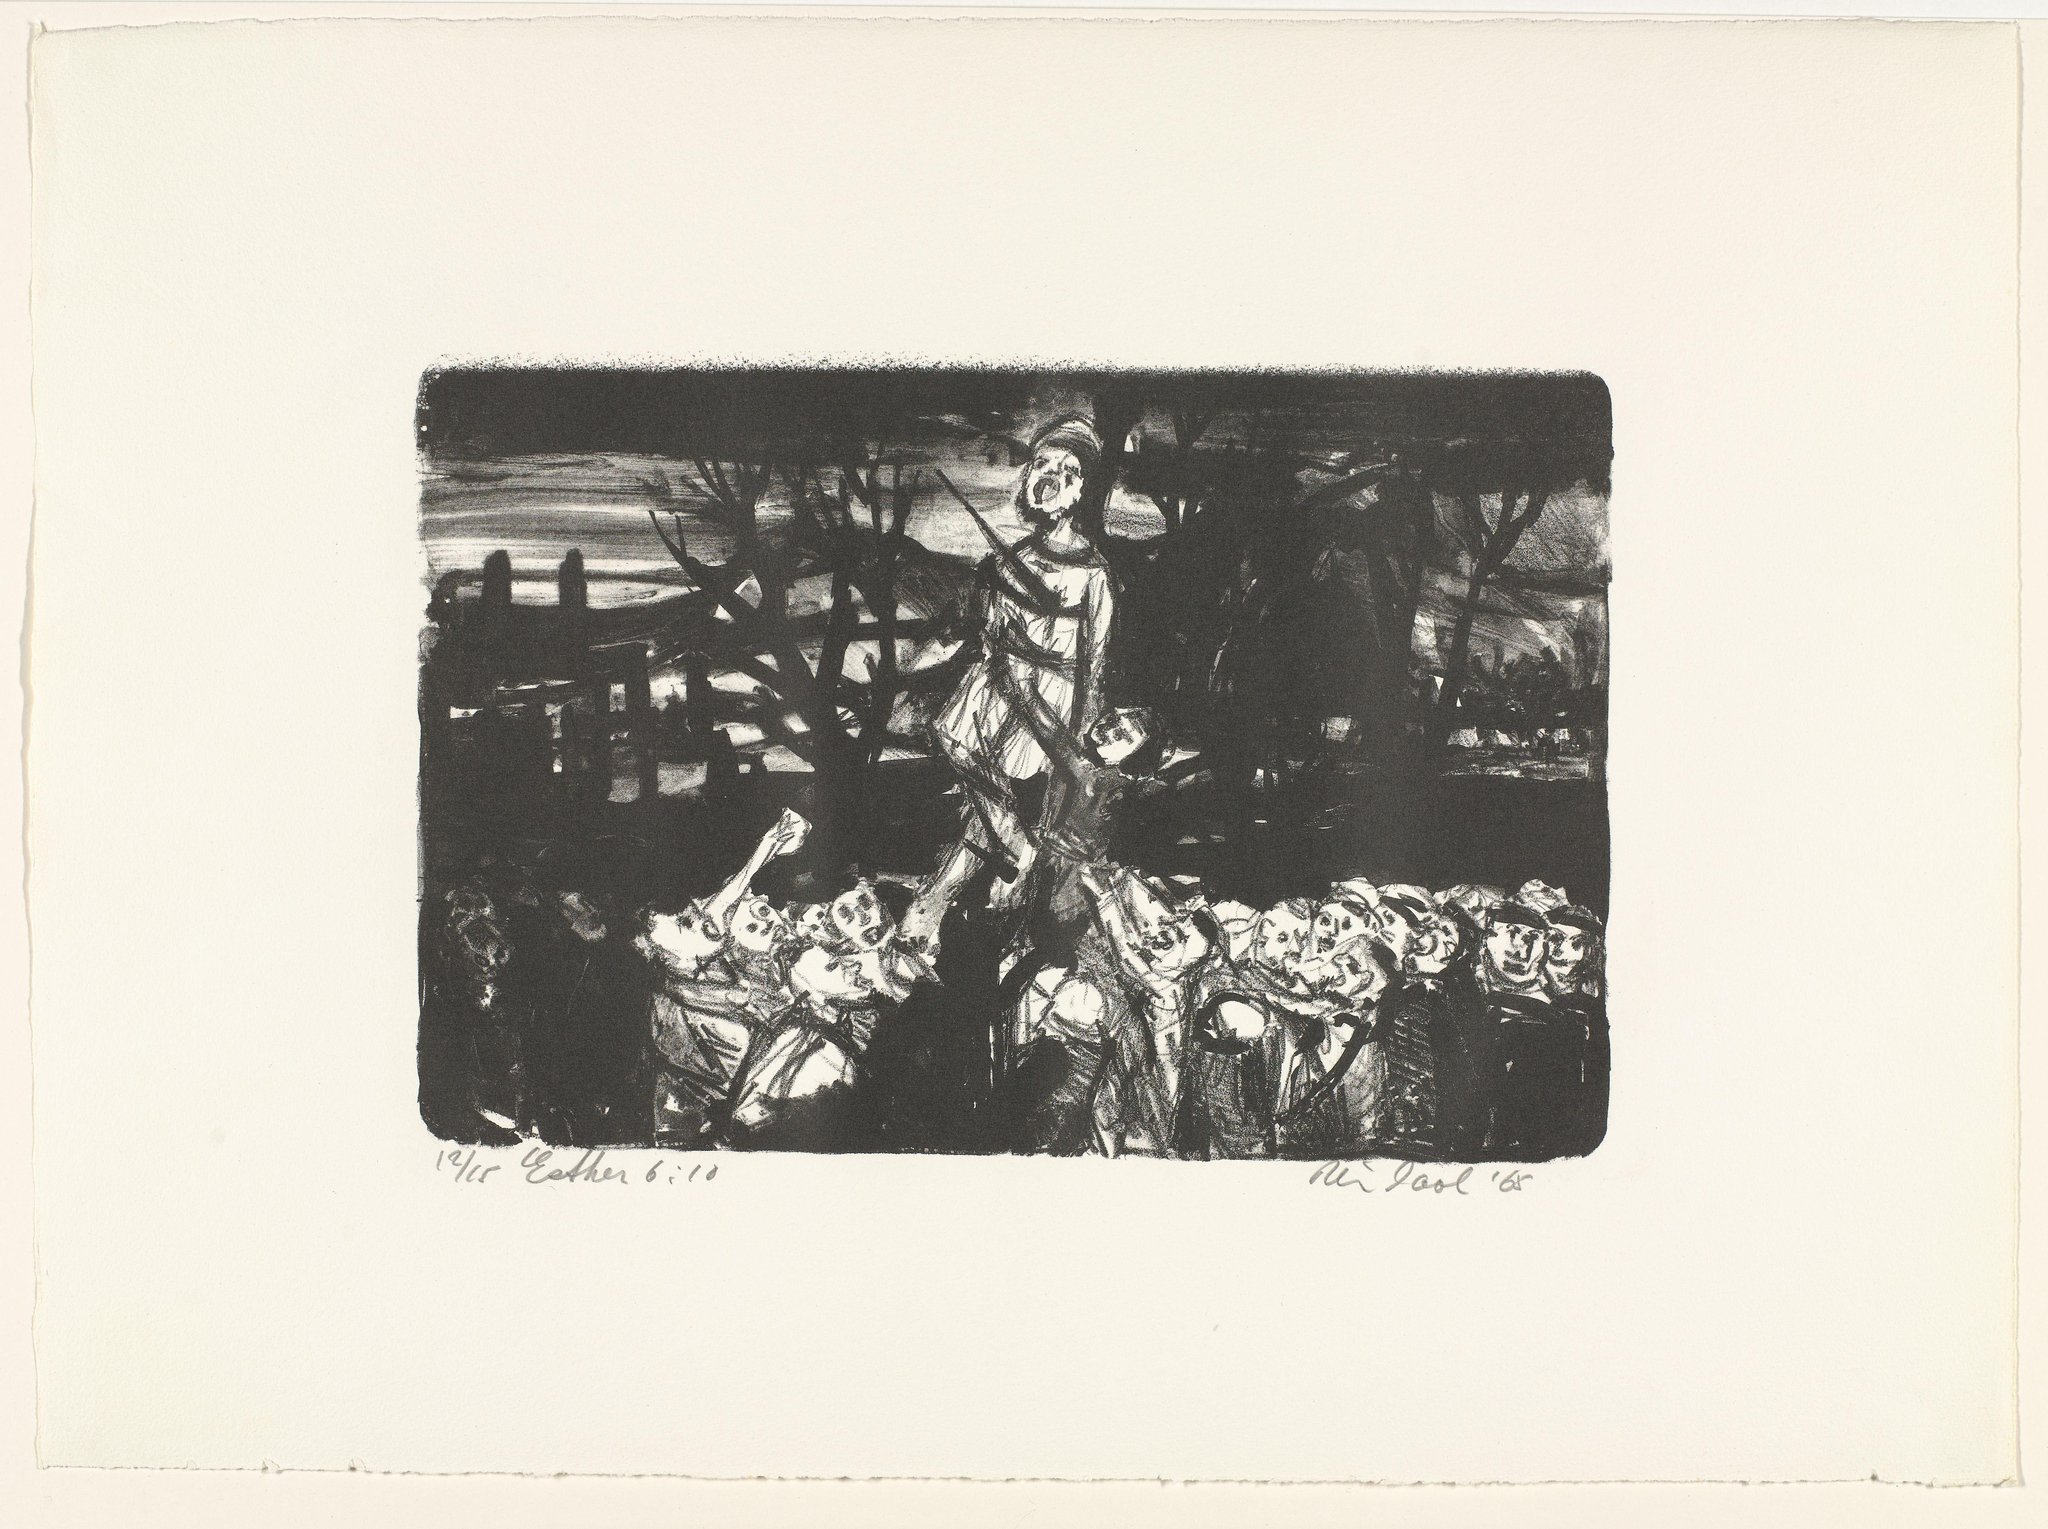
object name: print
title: Esther 6:10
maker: rein dool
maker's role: draughtsman, painter, print maker, sculptor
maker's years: 1933-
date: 1965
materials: paper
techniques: lithograph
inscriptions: edition: ‘12/15’, title: ‘Esther 6:10’, signature and date: ‘Rein Dool '65’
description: Boven een massa mensen uittorenende schreeuwende vrouw.